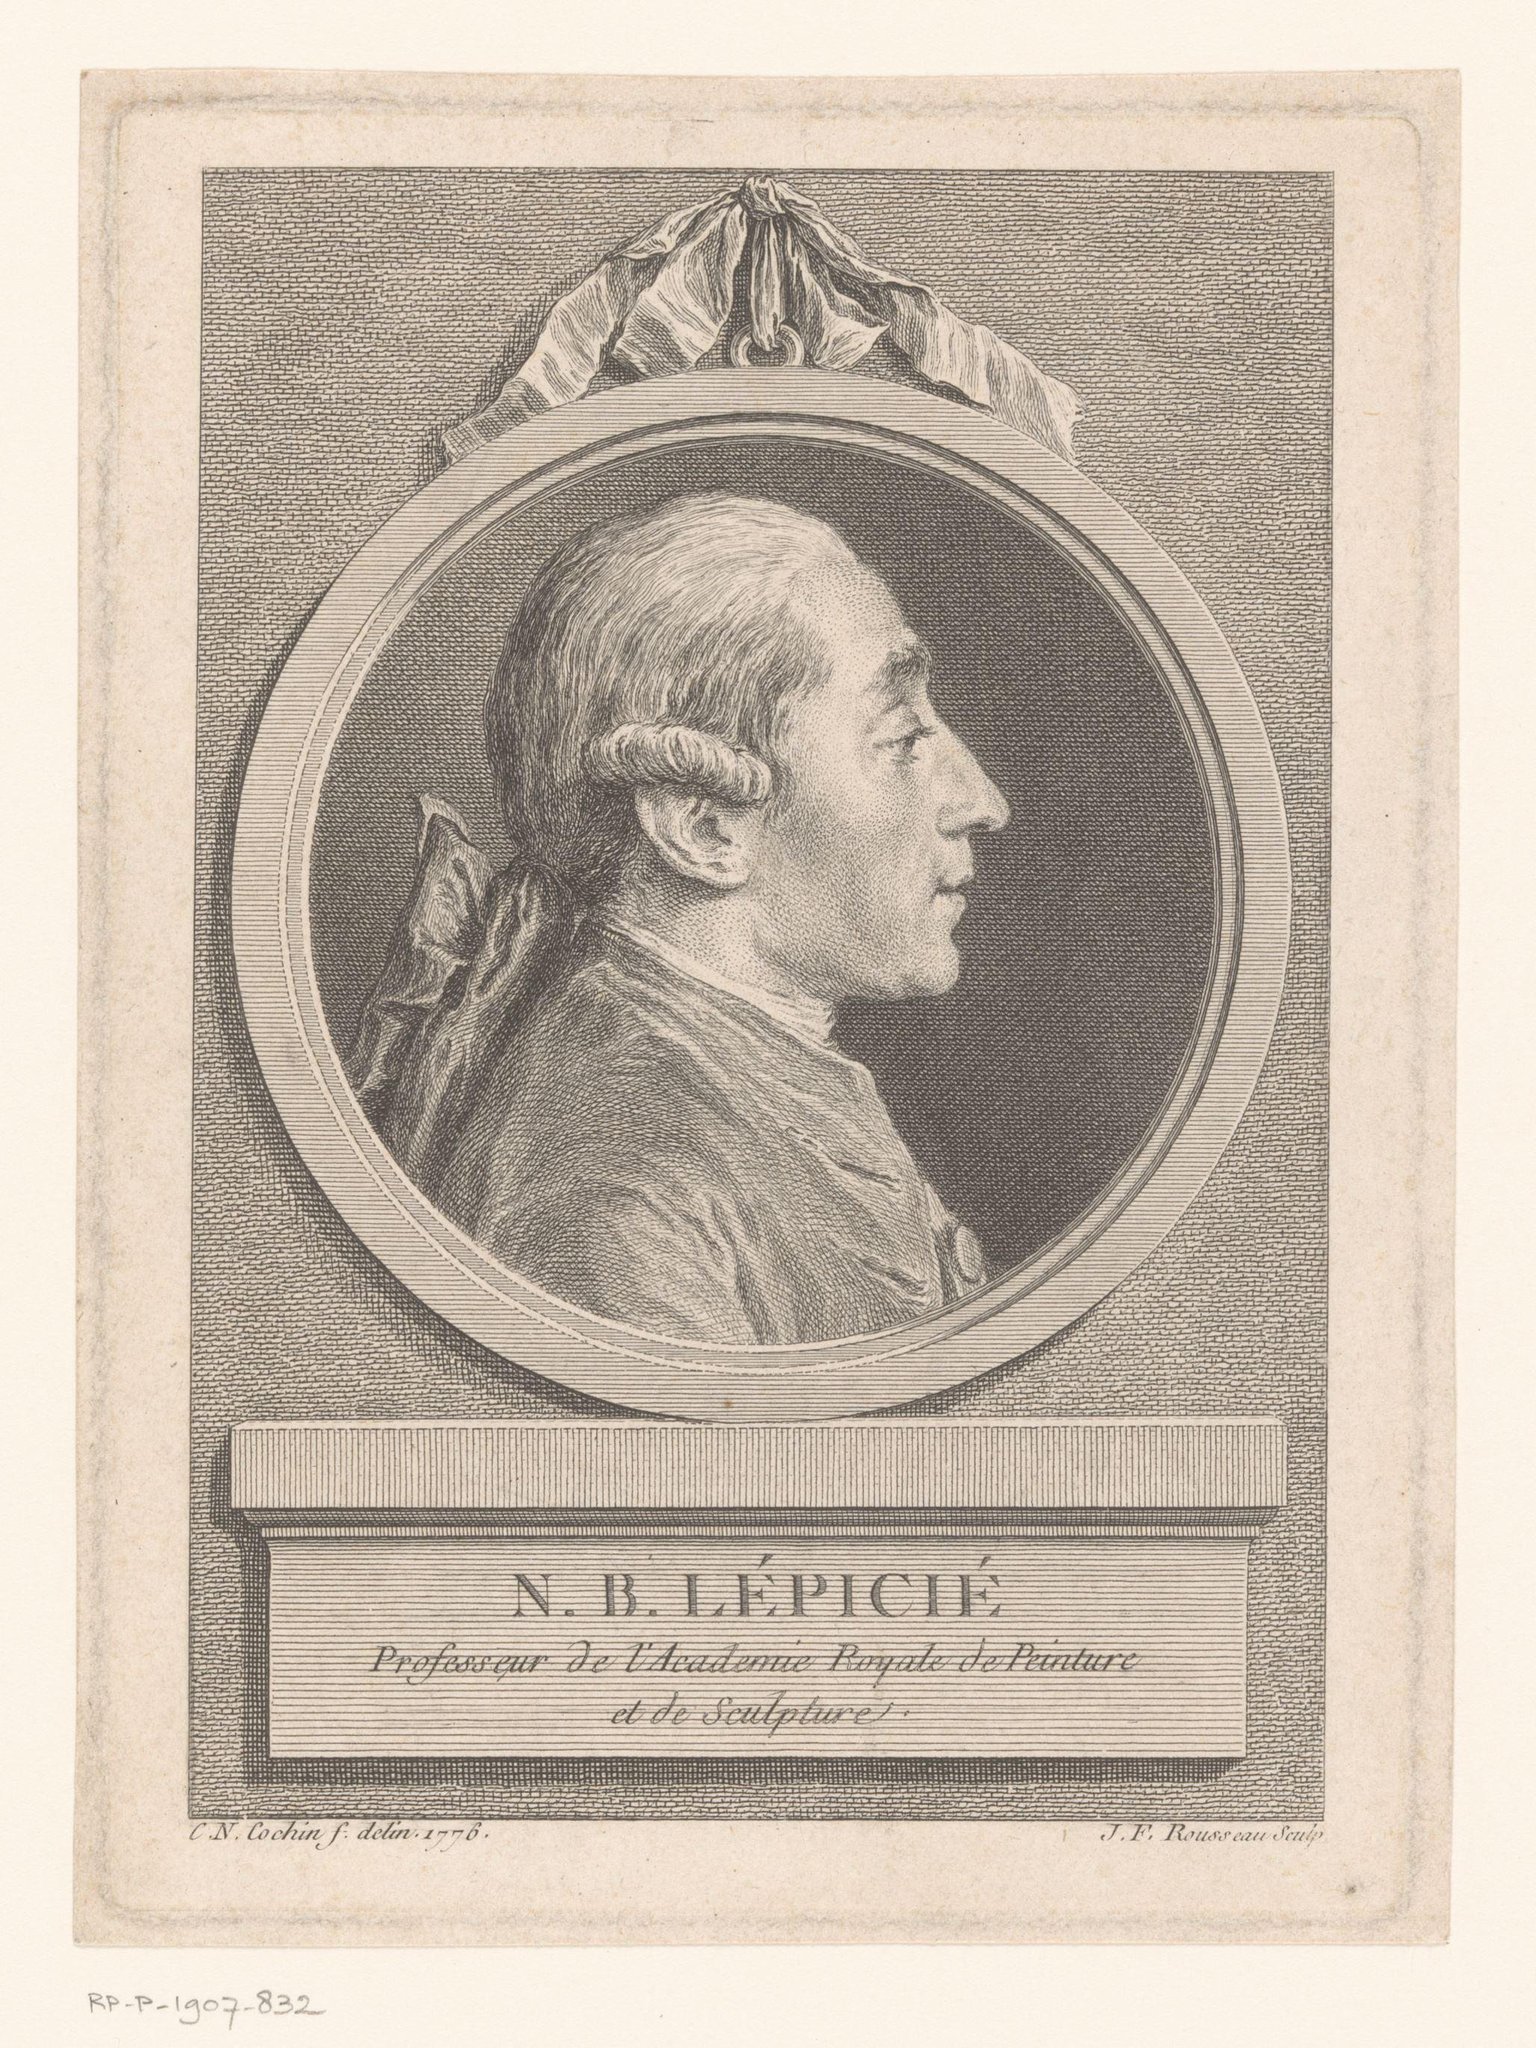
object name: print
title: Portret van Nicolas Bernard Lépicié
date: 1776-1780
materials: paper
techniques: engraving, etching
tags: paris, painter, nicolas bernard lépicié, historical persons, portrait, self-portrait of painter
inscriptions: collector's mark: Lugt 2228